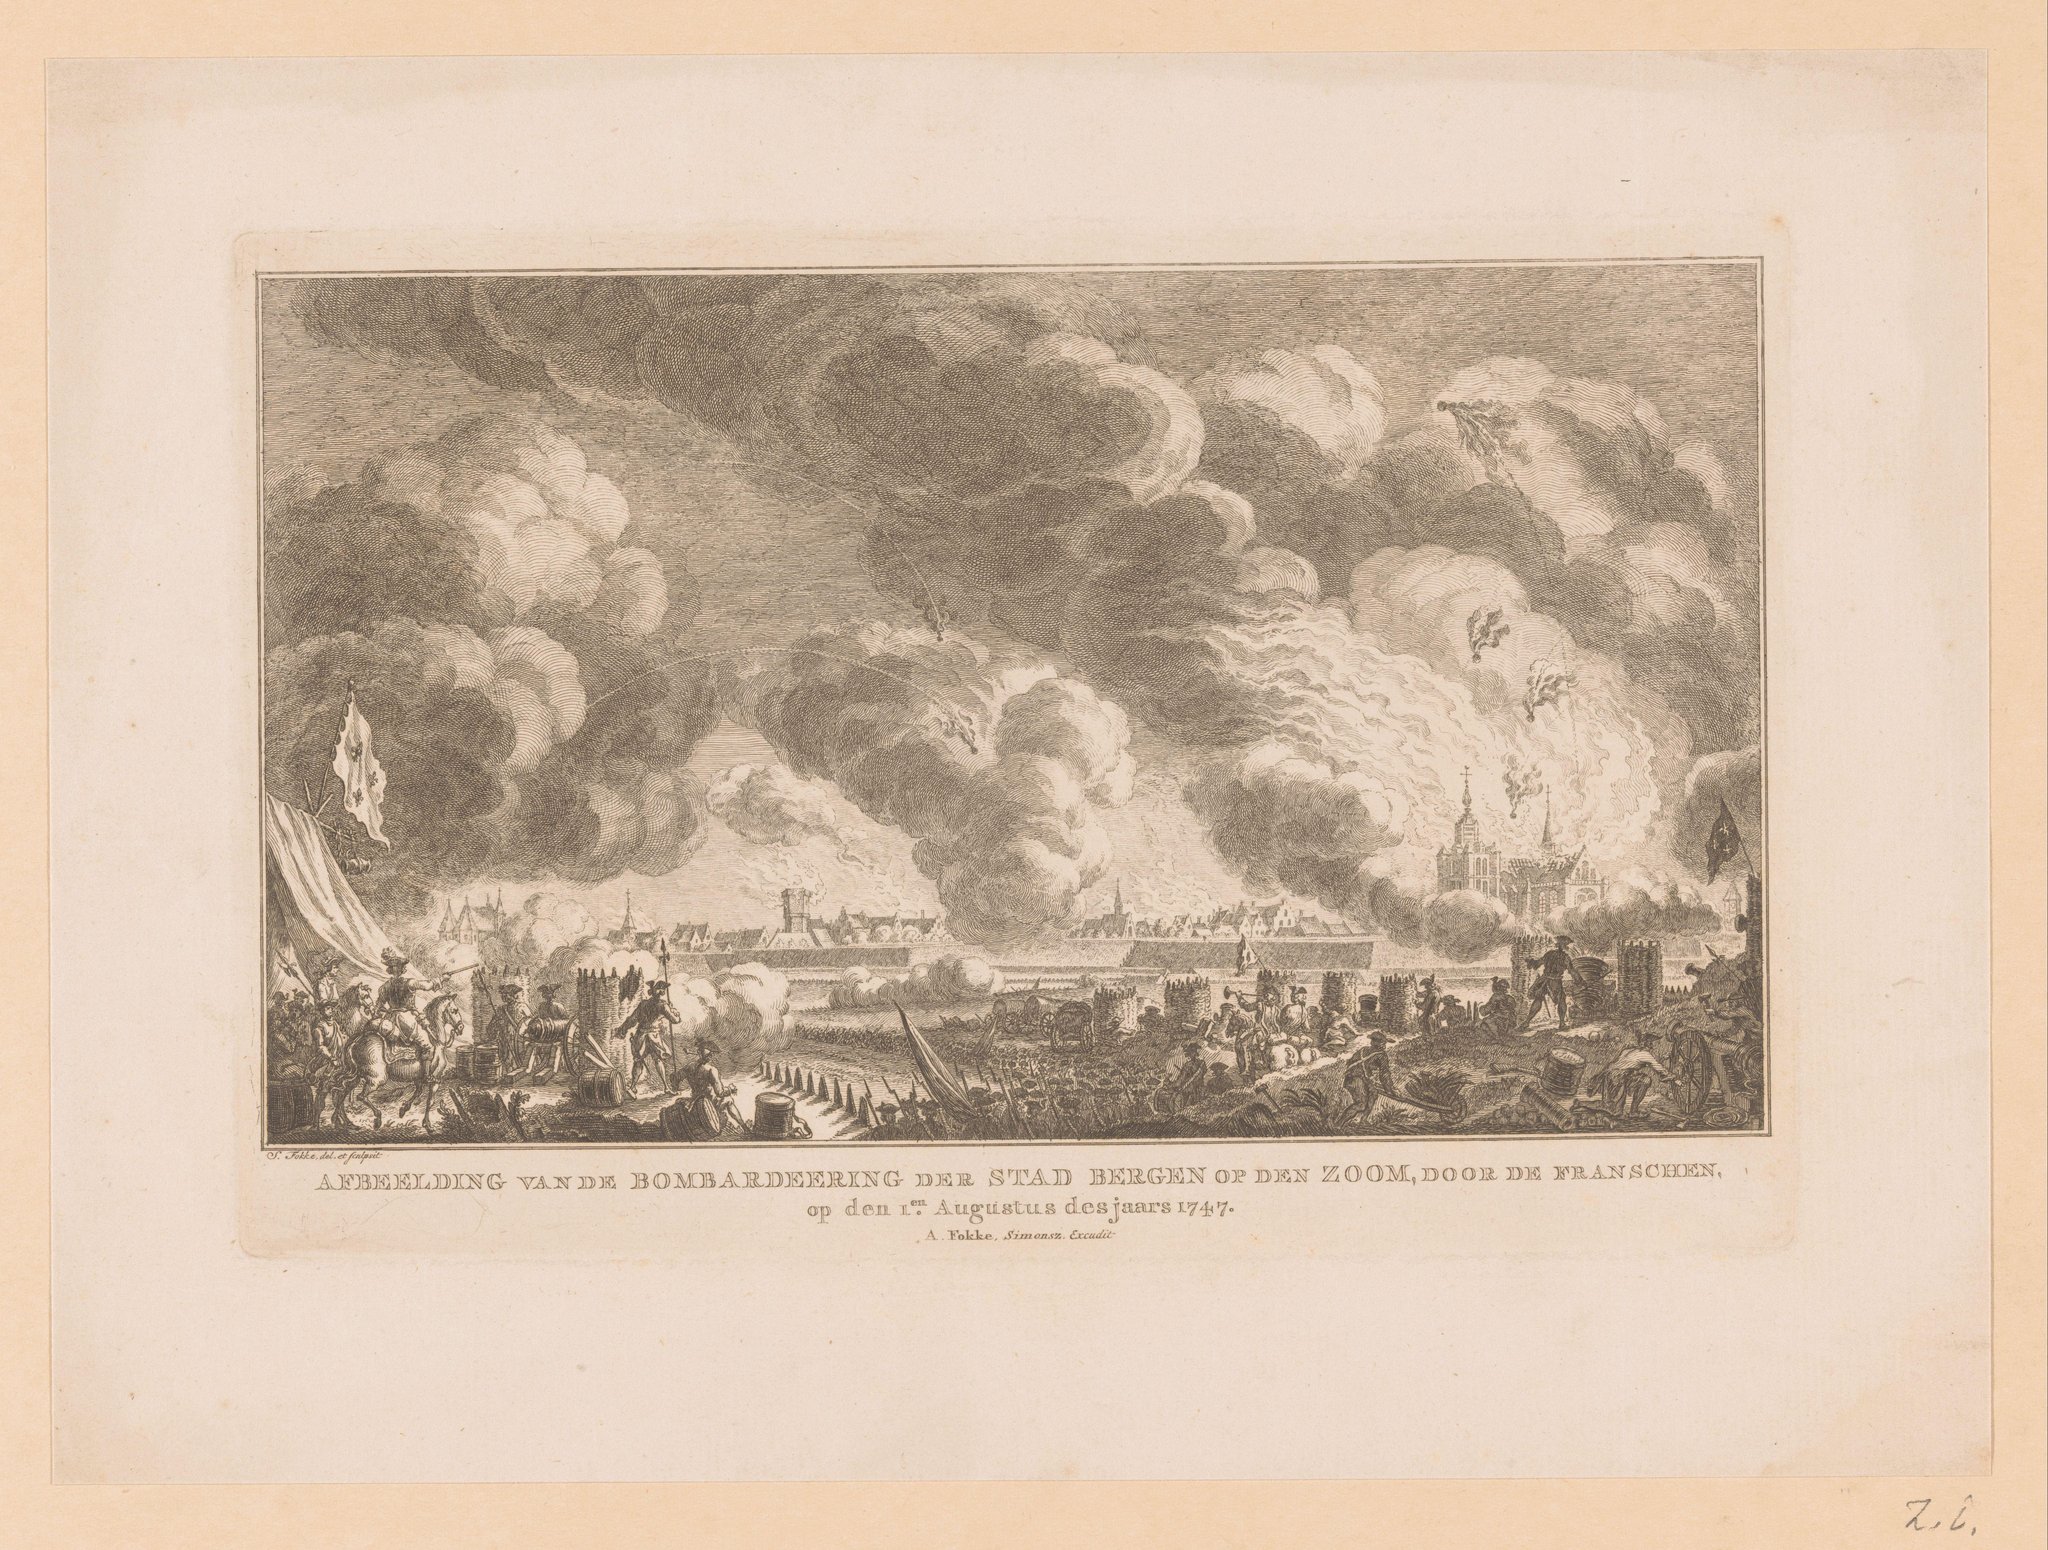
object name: print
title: Afbeelding van de bombardeering der stad Bergen op den Zoom, door de Franschen, op den 1.en augustus des jaars 1747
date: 1772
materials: paper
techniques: etching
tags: siege, bergen op zoom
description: Muller geeft aan dat de prenten door Simon Fokke in 1772 naar de tekeningen van Pronk uit 1748 zijn vervaardigd. In de Collecties Thuis in Brabant (collecties in Brabantse musea en archieven) is een ontwerptekening (met inv.nr.: BC-Tha oai:tha.uvt.nl:709121) voor een prent in de serie bewaard met de annotatie: Hoogstraat. na t Leven geschest (sic) door C.Pronk 1748. opgetekent door S. Fokke 1772.